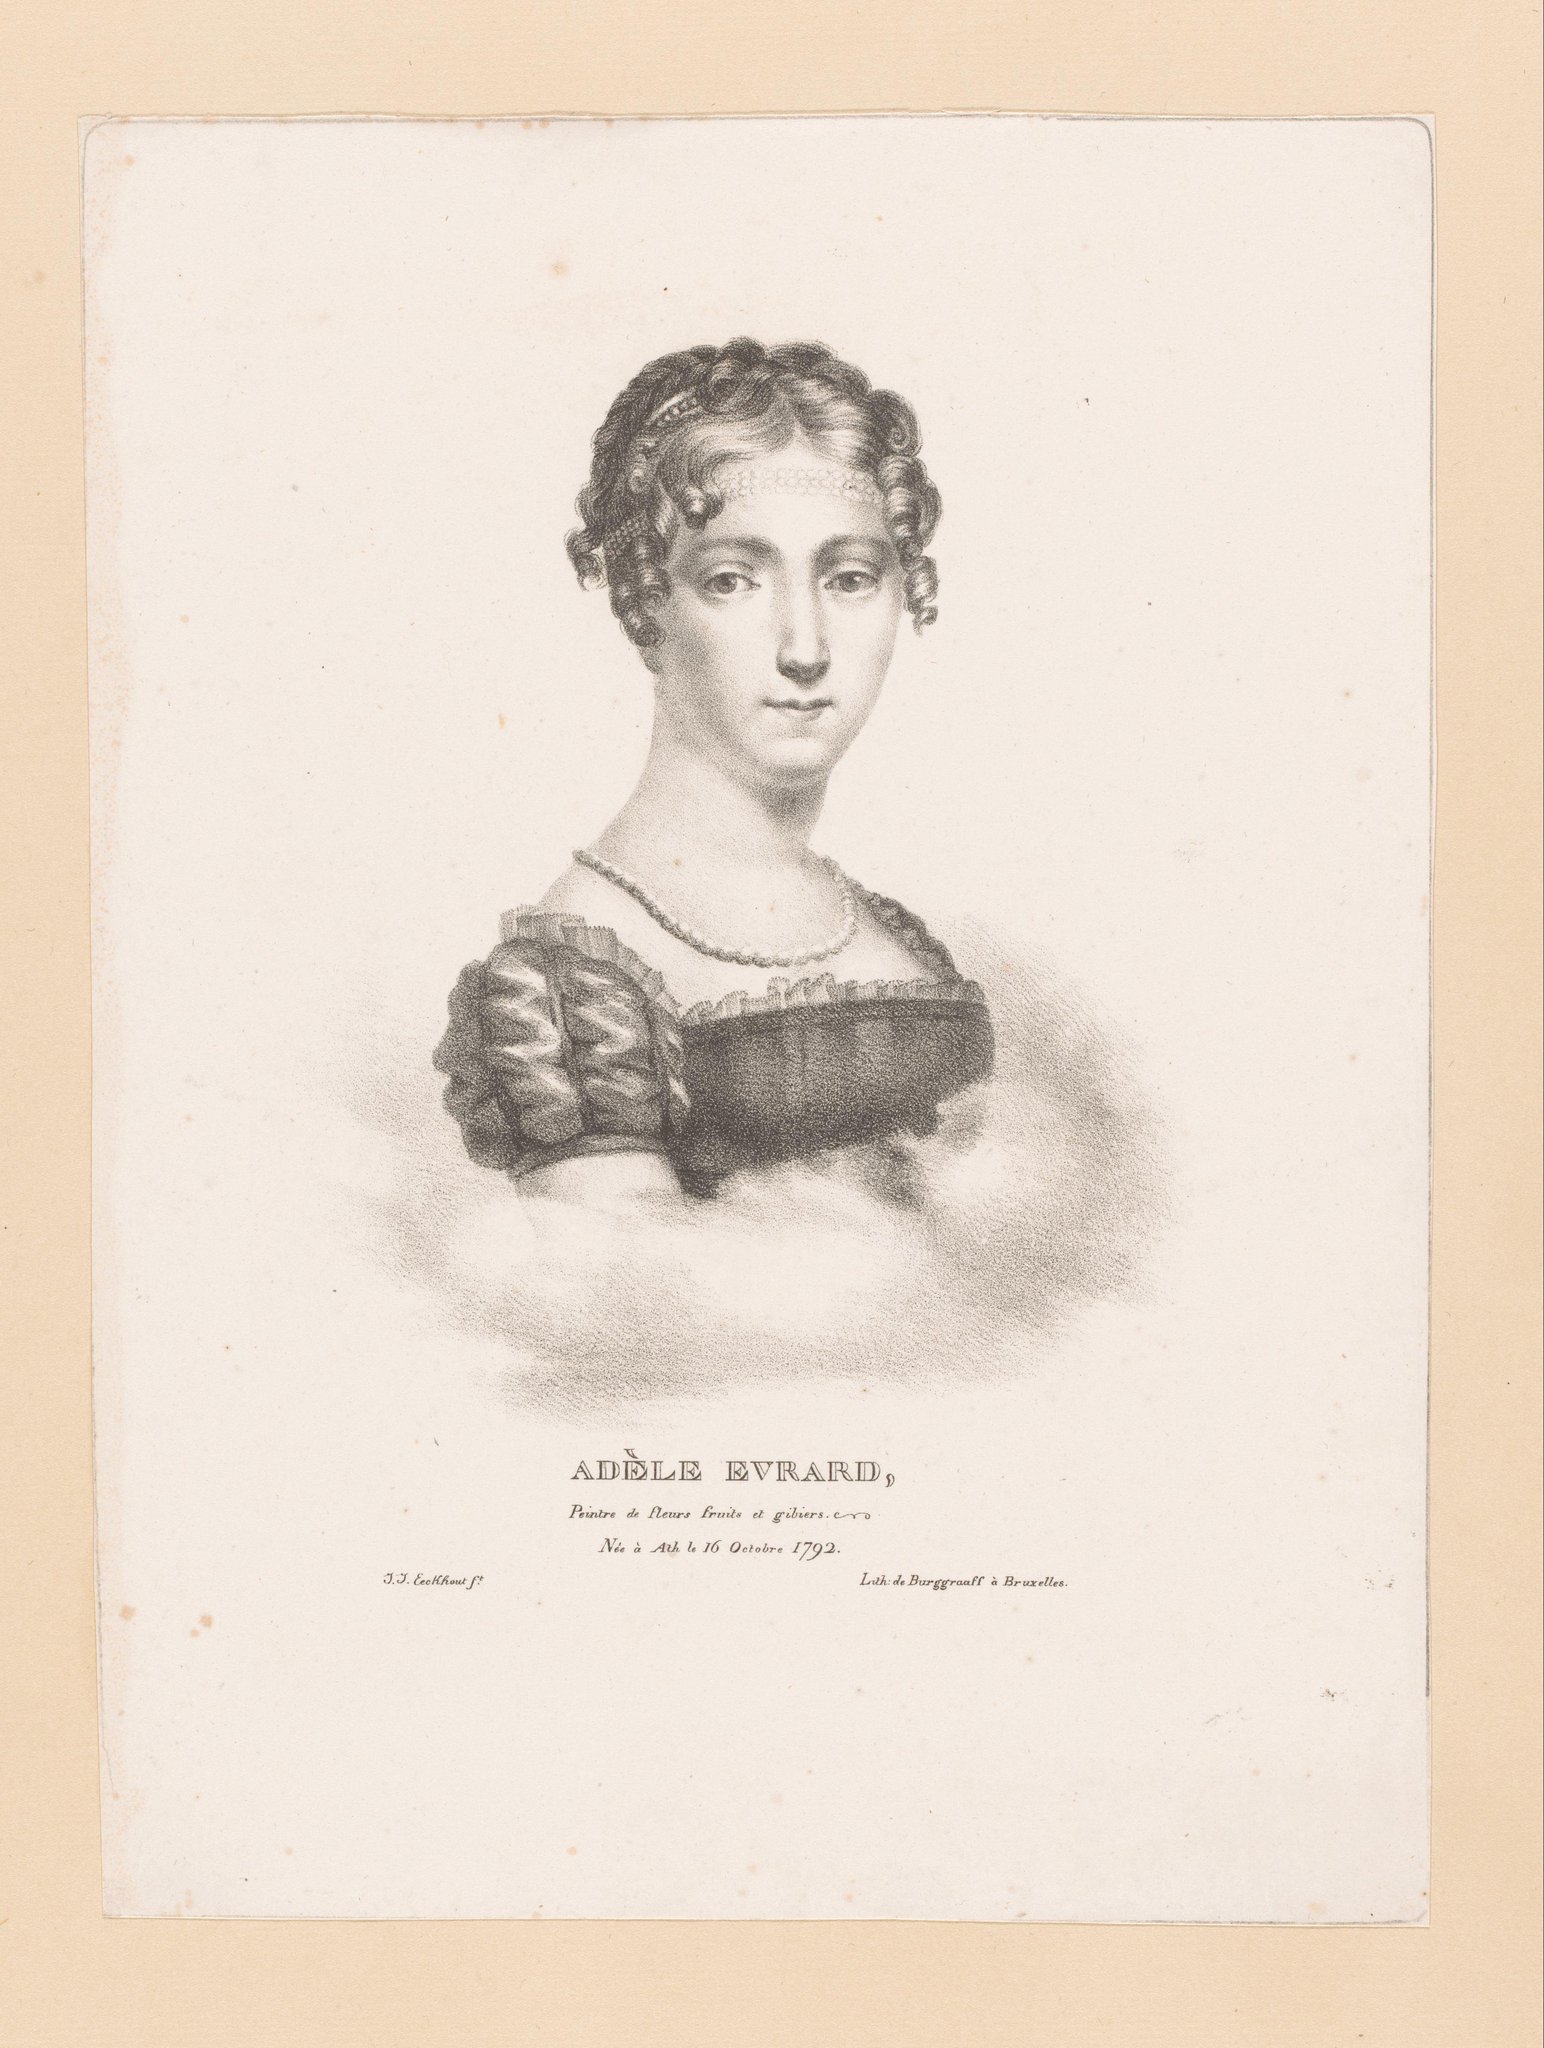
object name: print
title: Portraits des artistes modernes nés dans le Royaume des Pays-Bas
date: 1822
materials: paper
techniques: lithograph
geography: brussels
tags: painter, adèle agnès evrard, historical persons, portrait, self-portrait of painter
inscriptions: collector's mark: Lugt 2228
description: Prent maakt deel uit van een serie van zestig prenten.